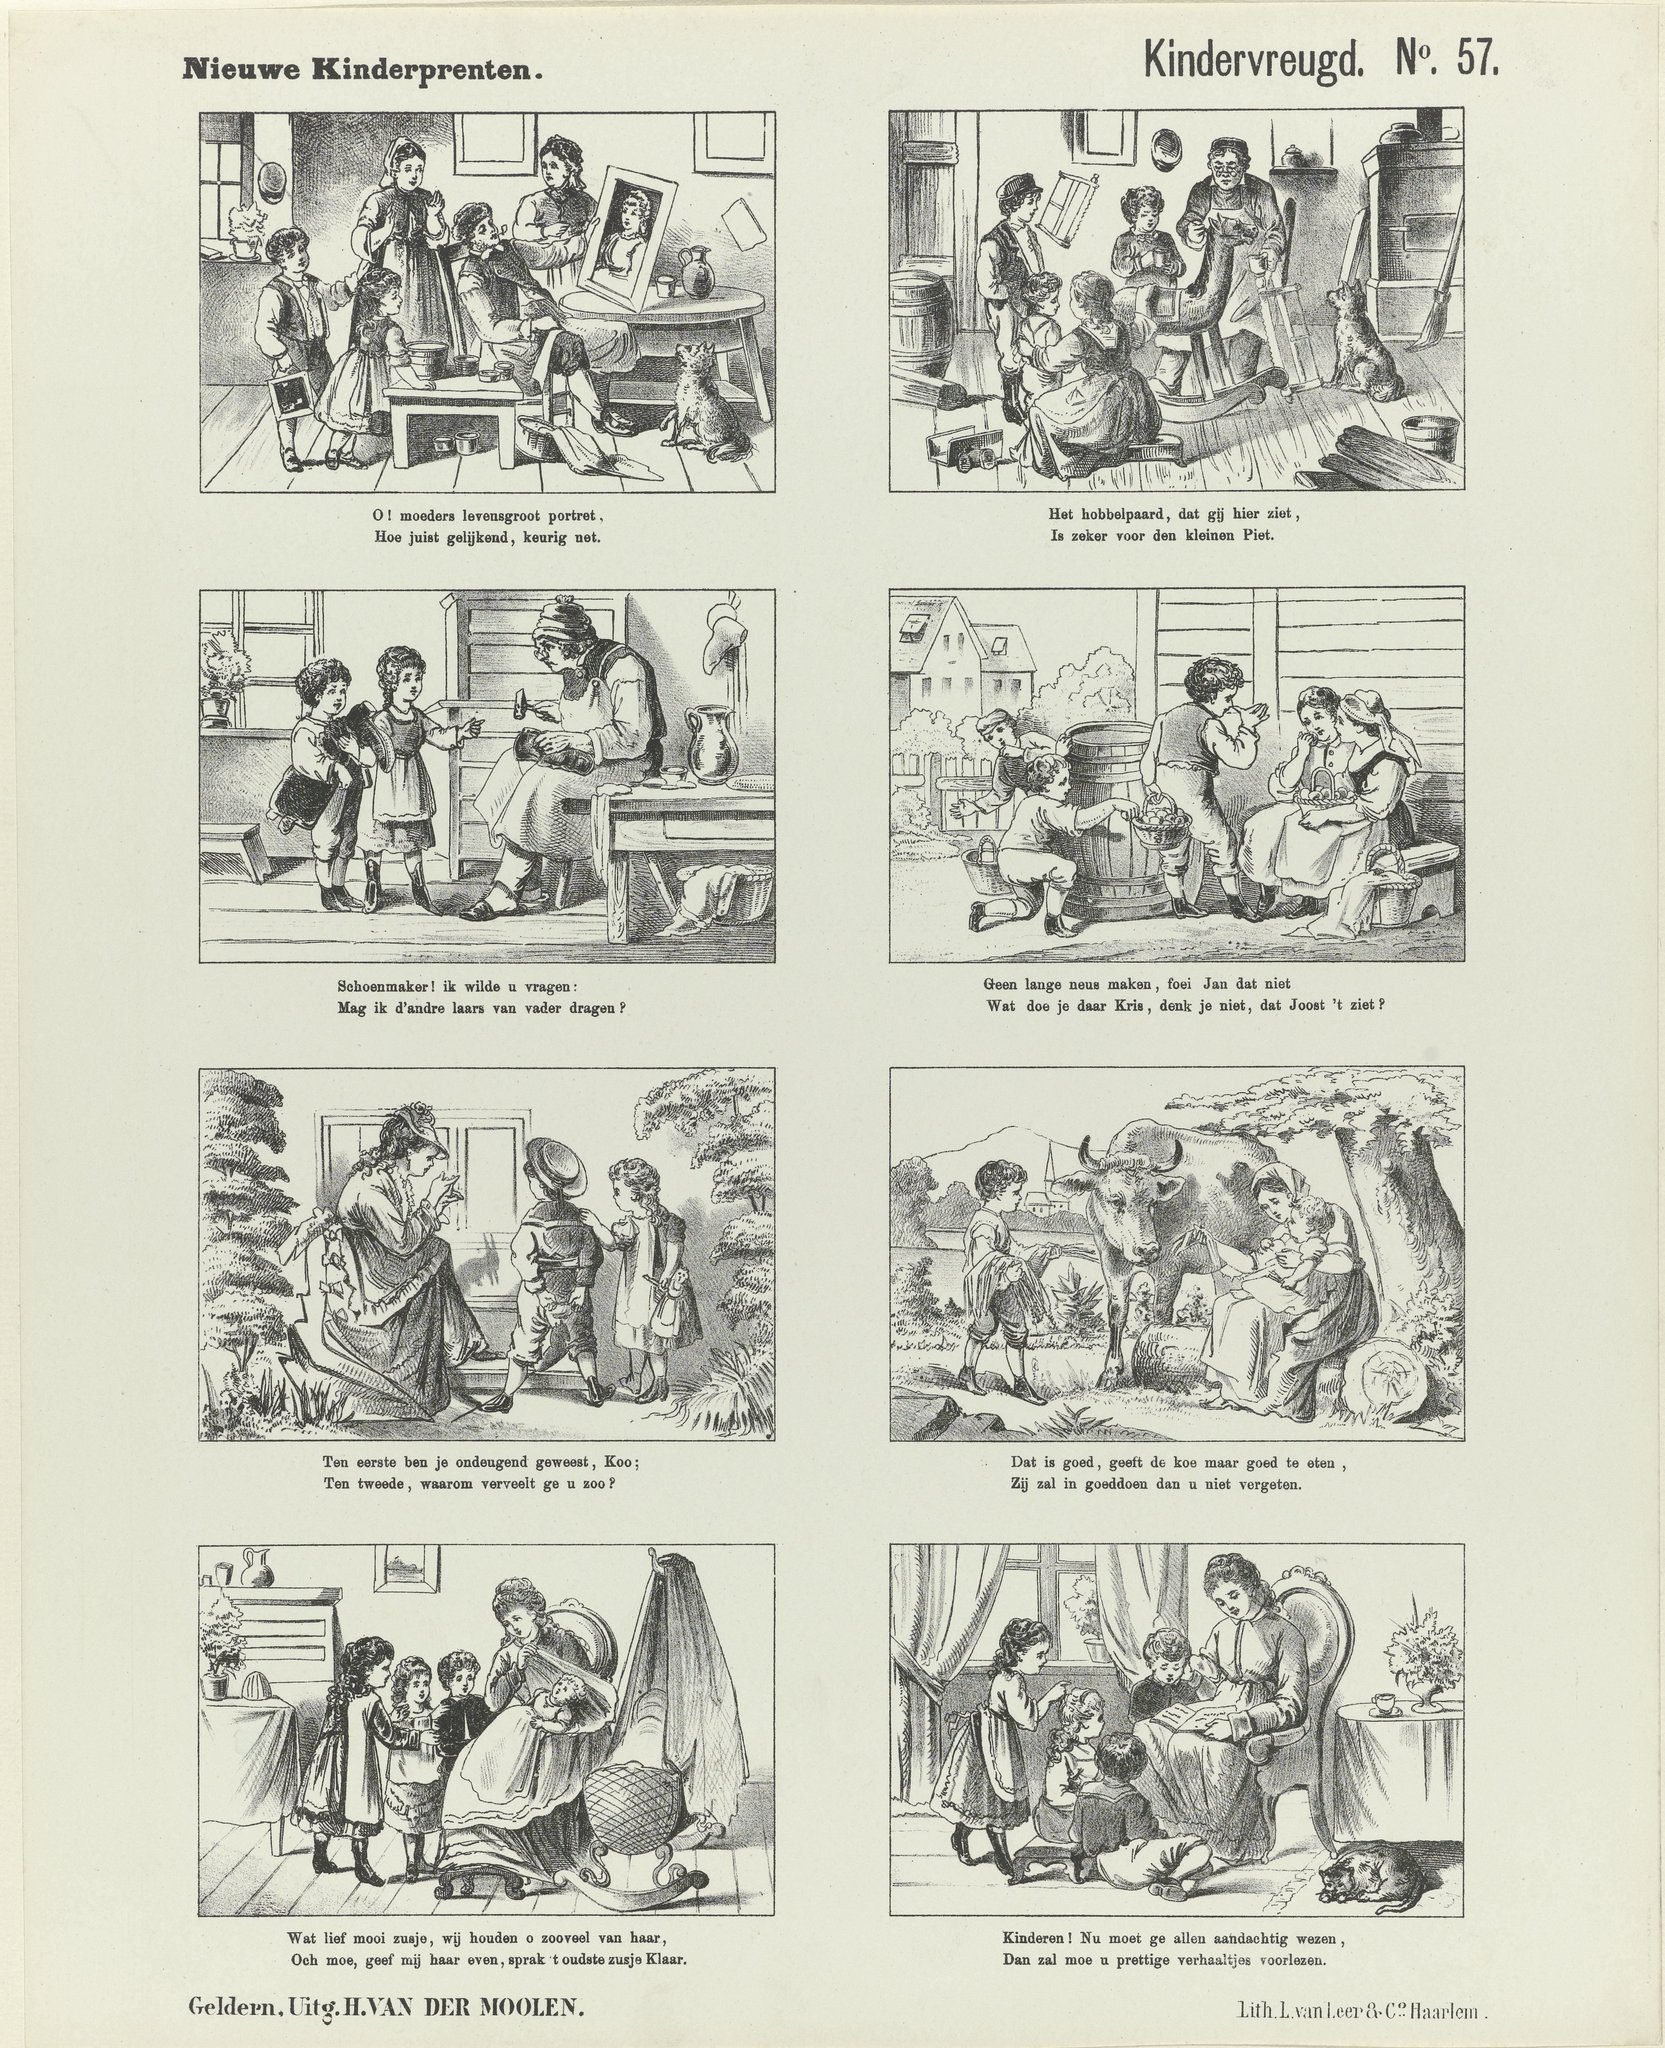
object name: print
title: Kindervreugd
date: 1838-1892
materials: paper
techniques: letterpress printing, lithograph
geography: geldern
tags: drawing, children's games and plays, rocking-horse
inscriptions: collector's mark: Lugt 2760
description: Blad met 8 voorstellingen van kinderspelen en bezigheden, waaronder rijden op een hobbelpaard, een koe voeren en voorgelezen worden. Onder elke afbeelding een tweeregelig vers. Genummerd rechtsboven: No. 57.